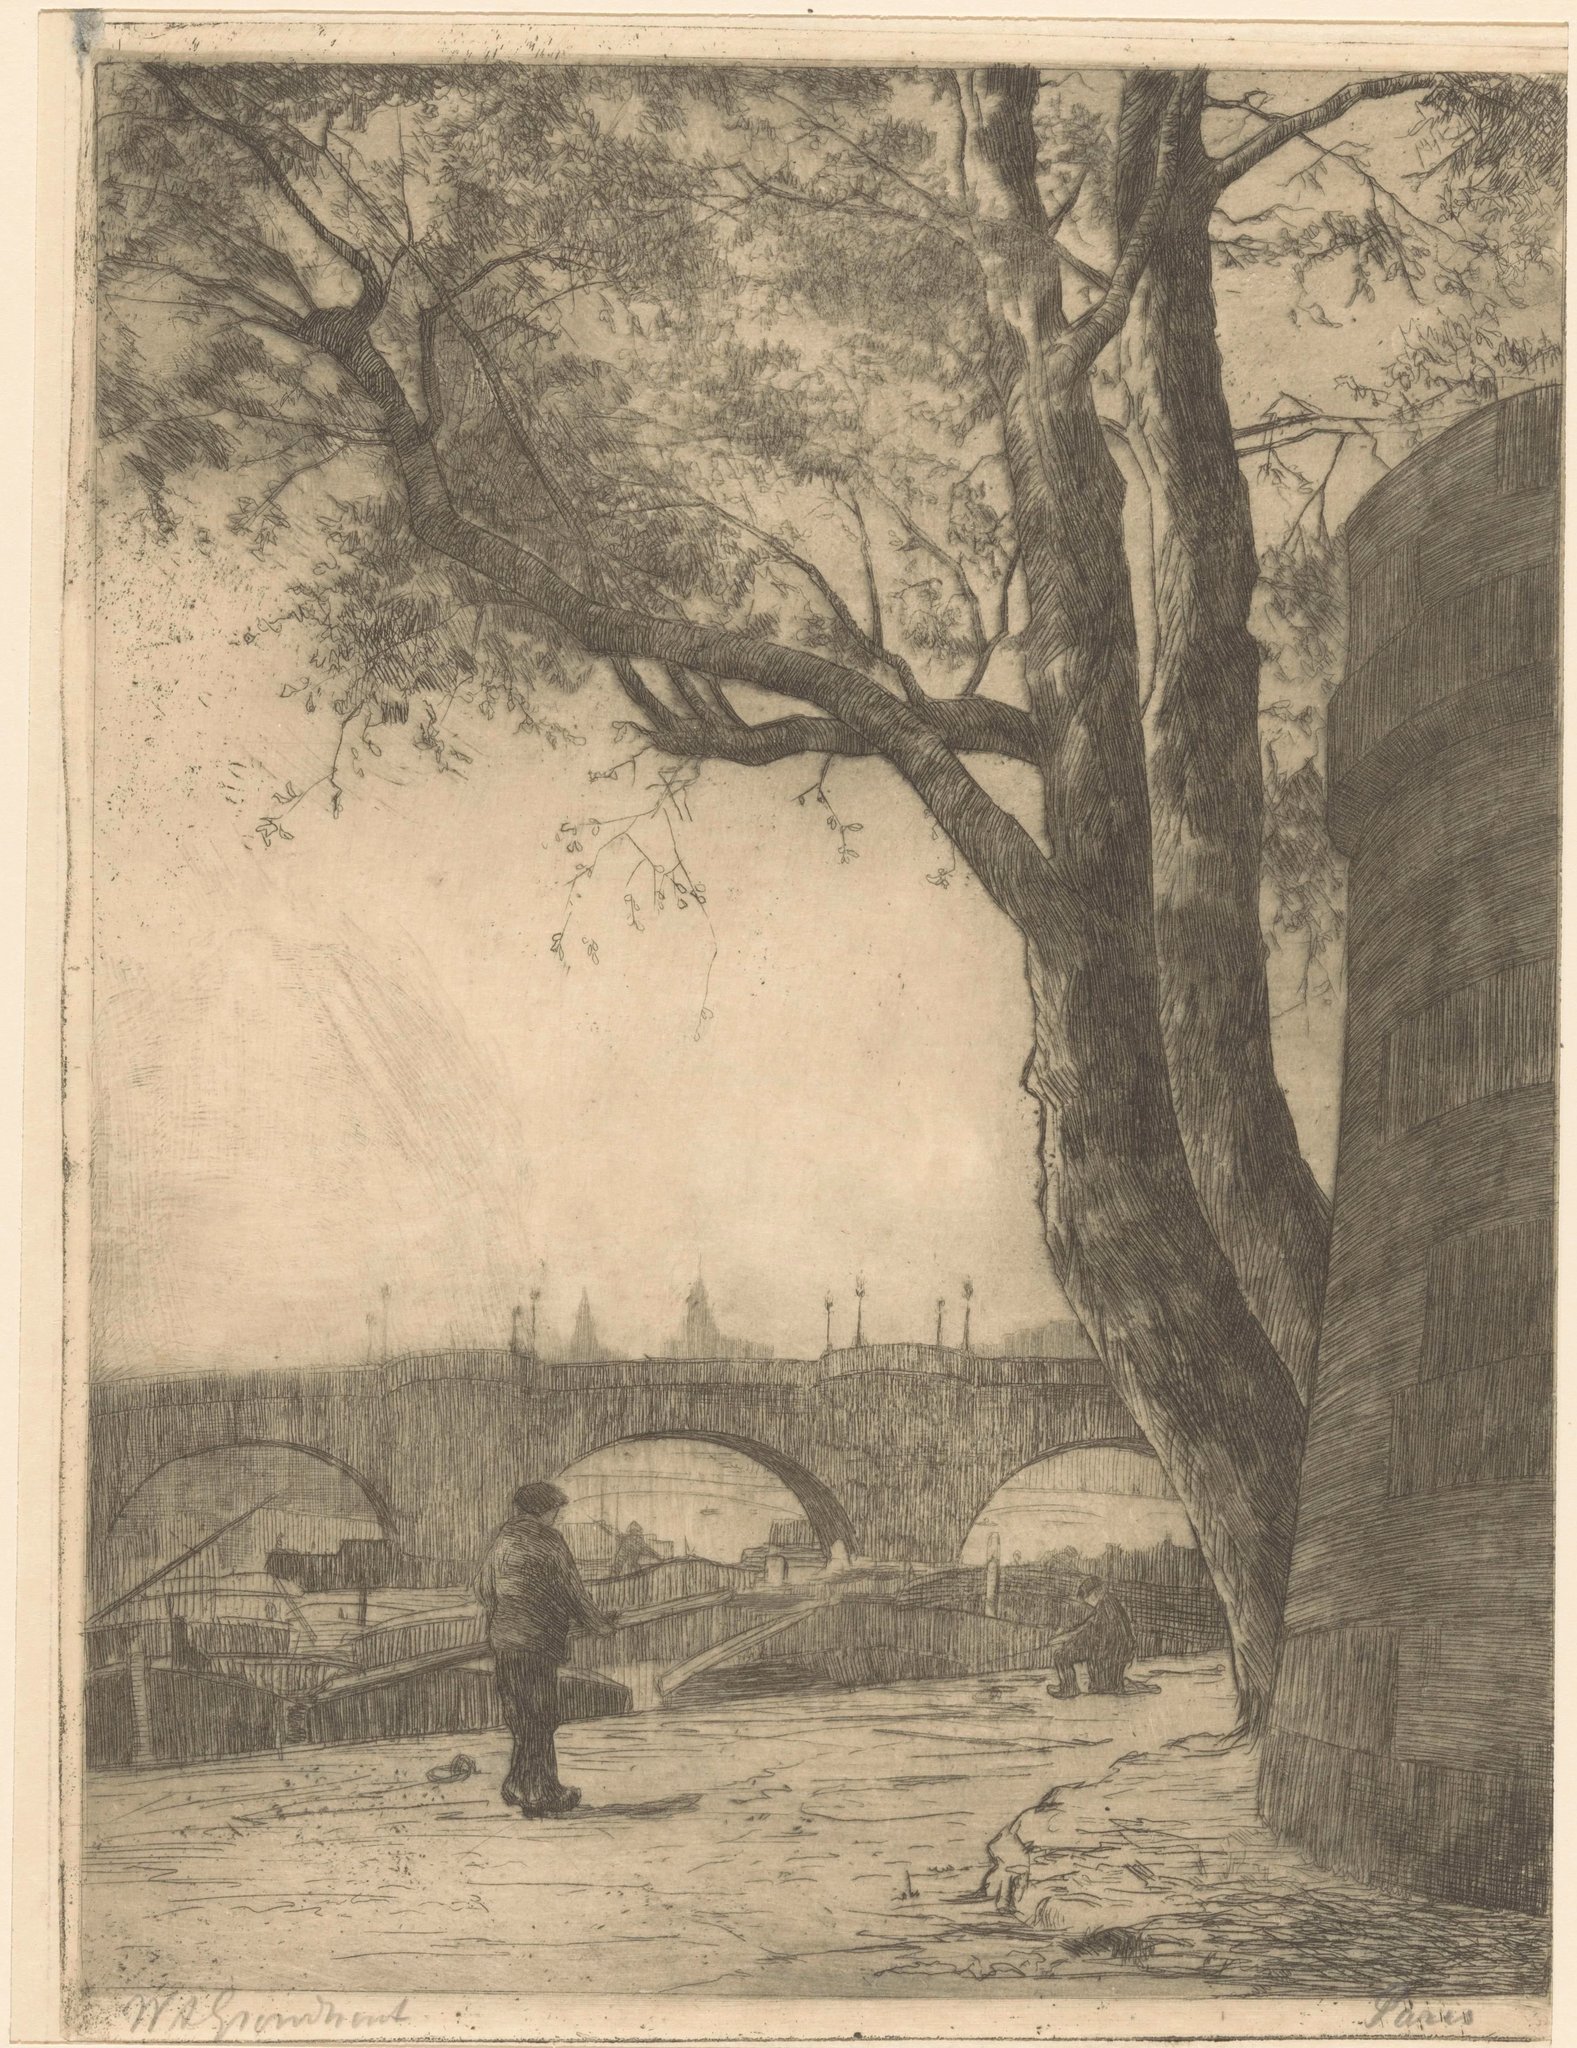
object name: print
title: Parijs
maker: willem adrianus grondhout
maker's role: draughtsman, painter, print maker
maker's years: 1878-1934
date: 1888-1934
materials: paper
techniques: etching, intaglio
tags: bridge in city across river, canal, etc., quay, paris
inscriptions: collector's mark: Lugt 2228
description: Een kade langs de Seine in Parijs. Rechts twee bomen. Op de achtergrond een brug.